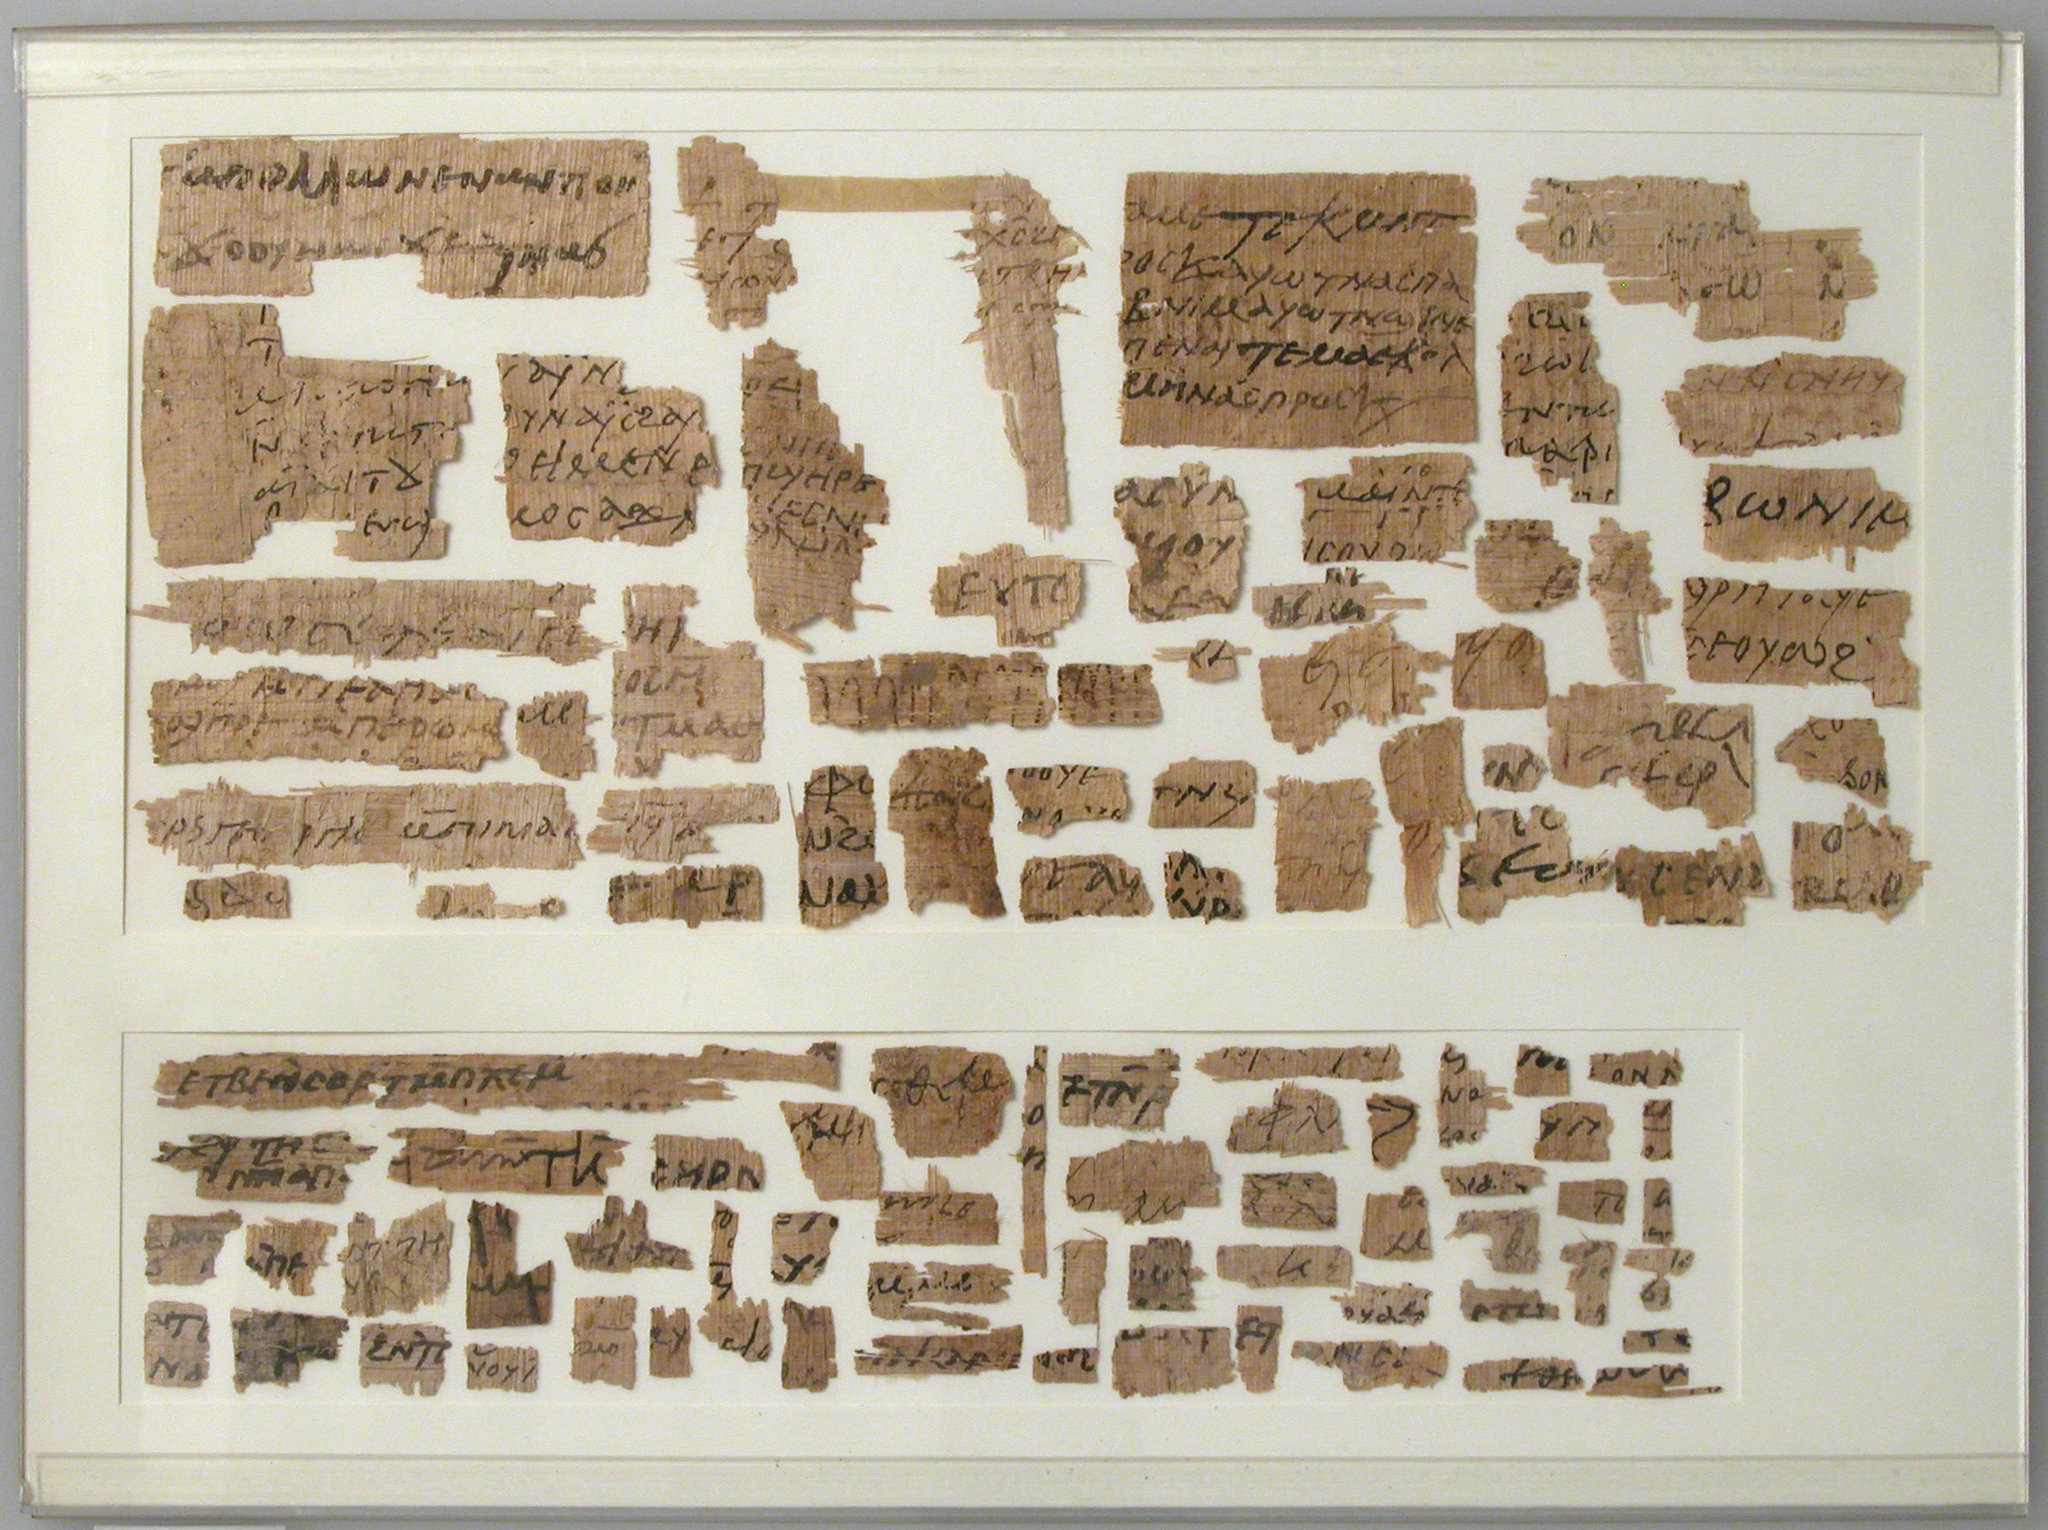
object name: fragment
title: Papyri Fragments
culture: coptic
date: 601-700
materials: ink, papyrus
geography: egypt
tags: documents